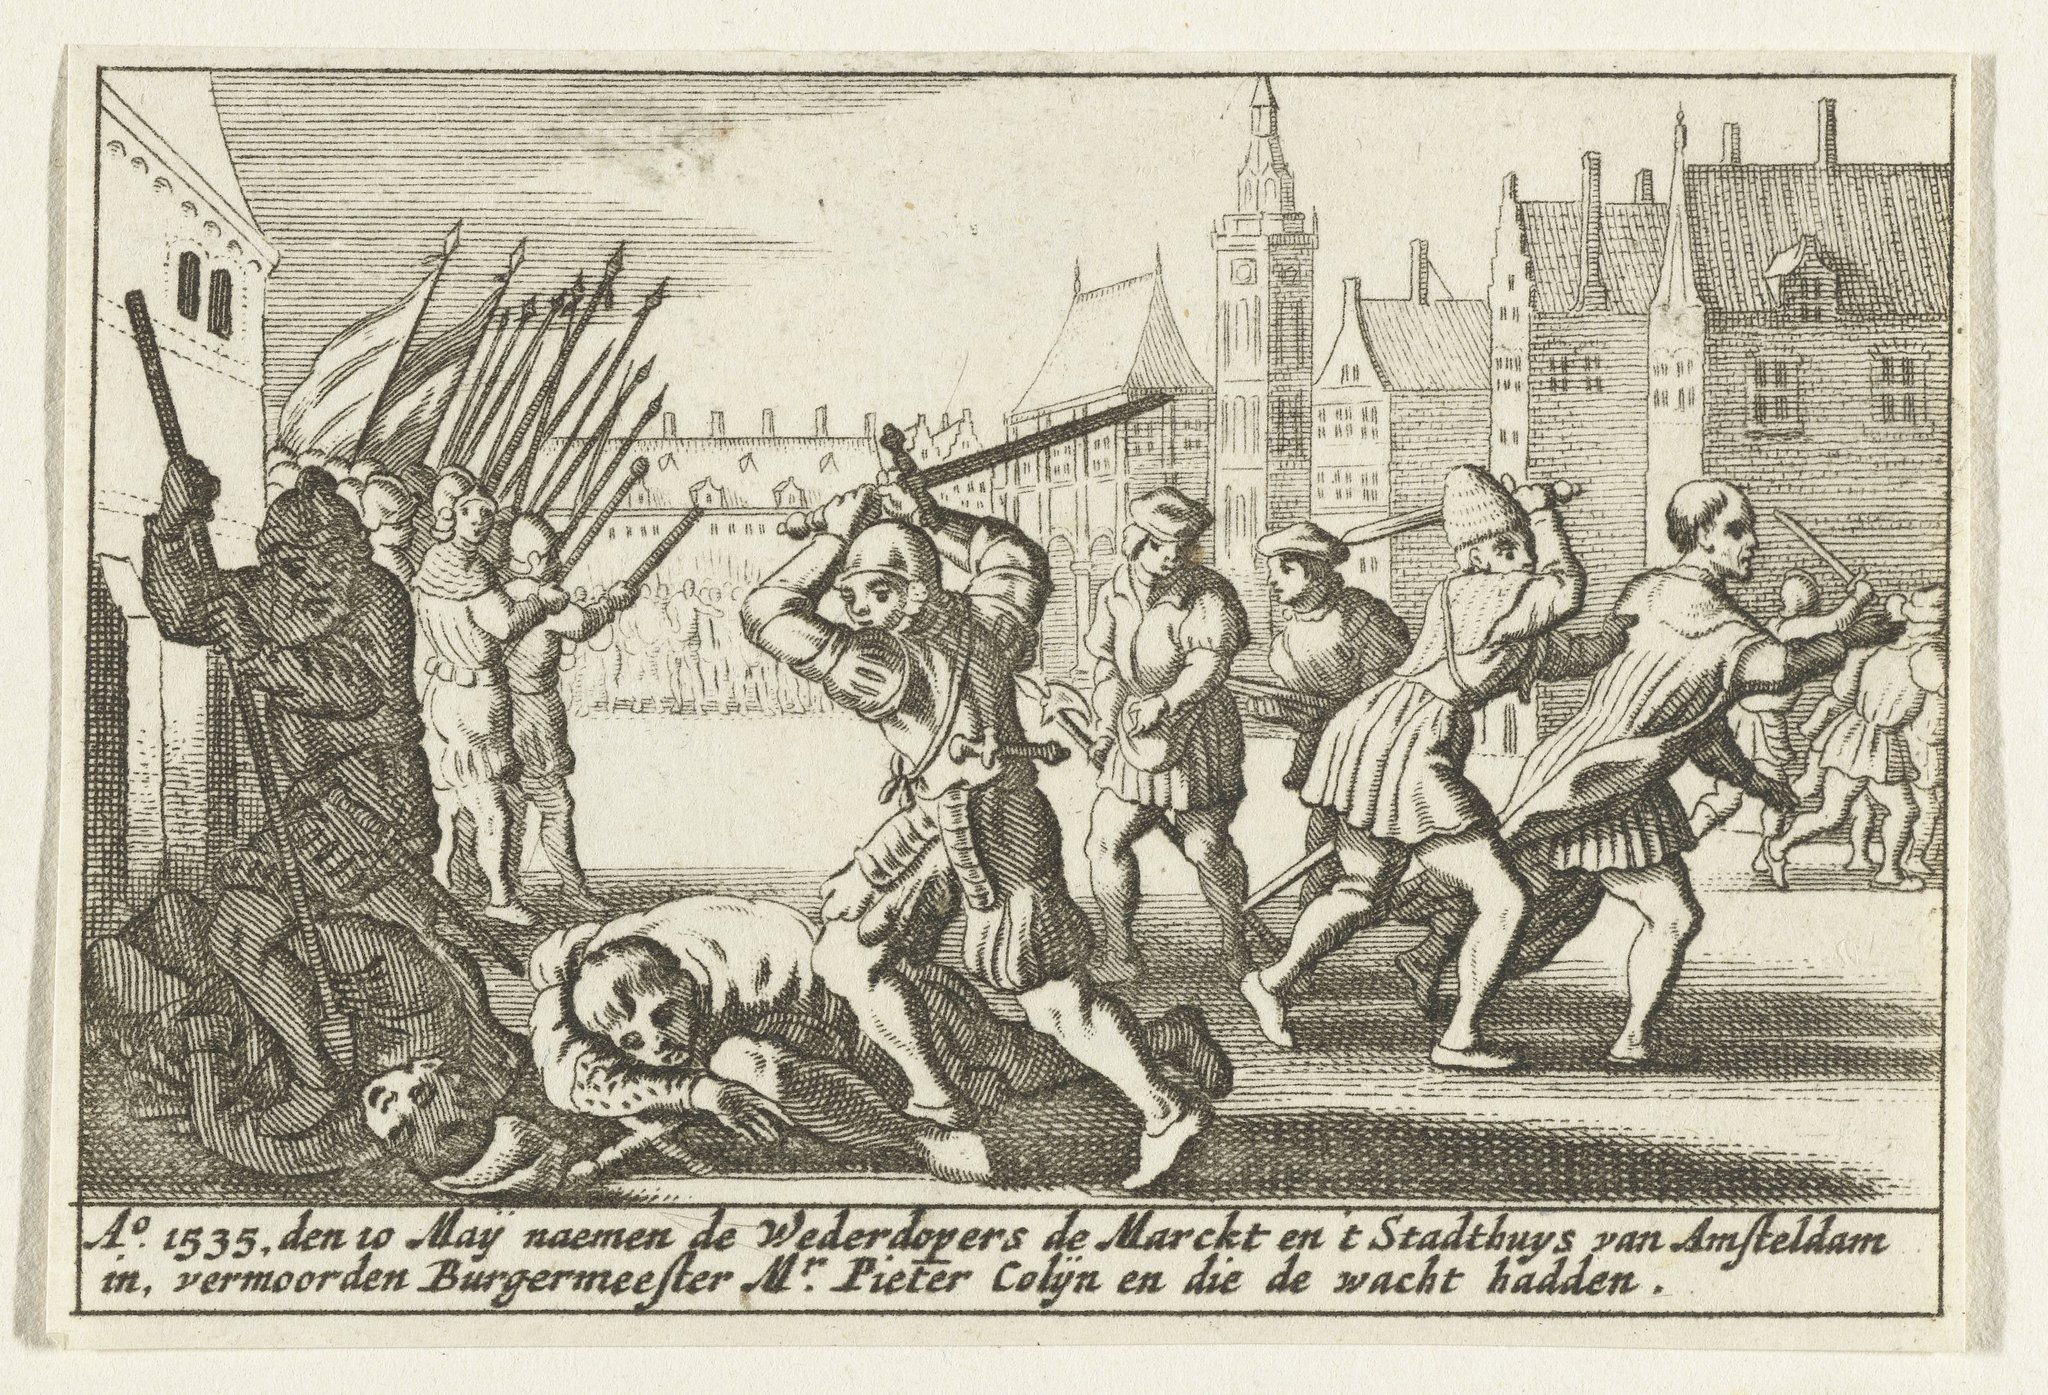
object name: print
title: Opstand van de wederdopers te Amsterdam in 1534-1535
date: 1629-1652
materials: paper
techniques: etching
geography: northern netherlands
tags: pieter colijn, dam, wederdopersoproer in amsterdam en friesland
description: Deze prenten zijn gebaseerd op de oorspronkelijke anonieme gravures in de eerste uitgave L. Hortensius, Van den oproer der weder-dooperen, 1614. Alle 8 prenten op op één blad geplakt. Naar het verloren gegane schilderij van Barend Dircksz. in het oude stadhuis te Amsterdam.